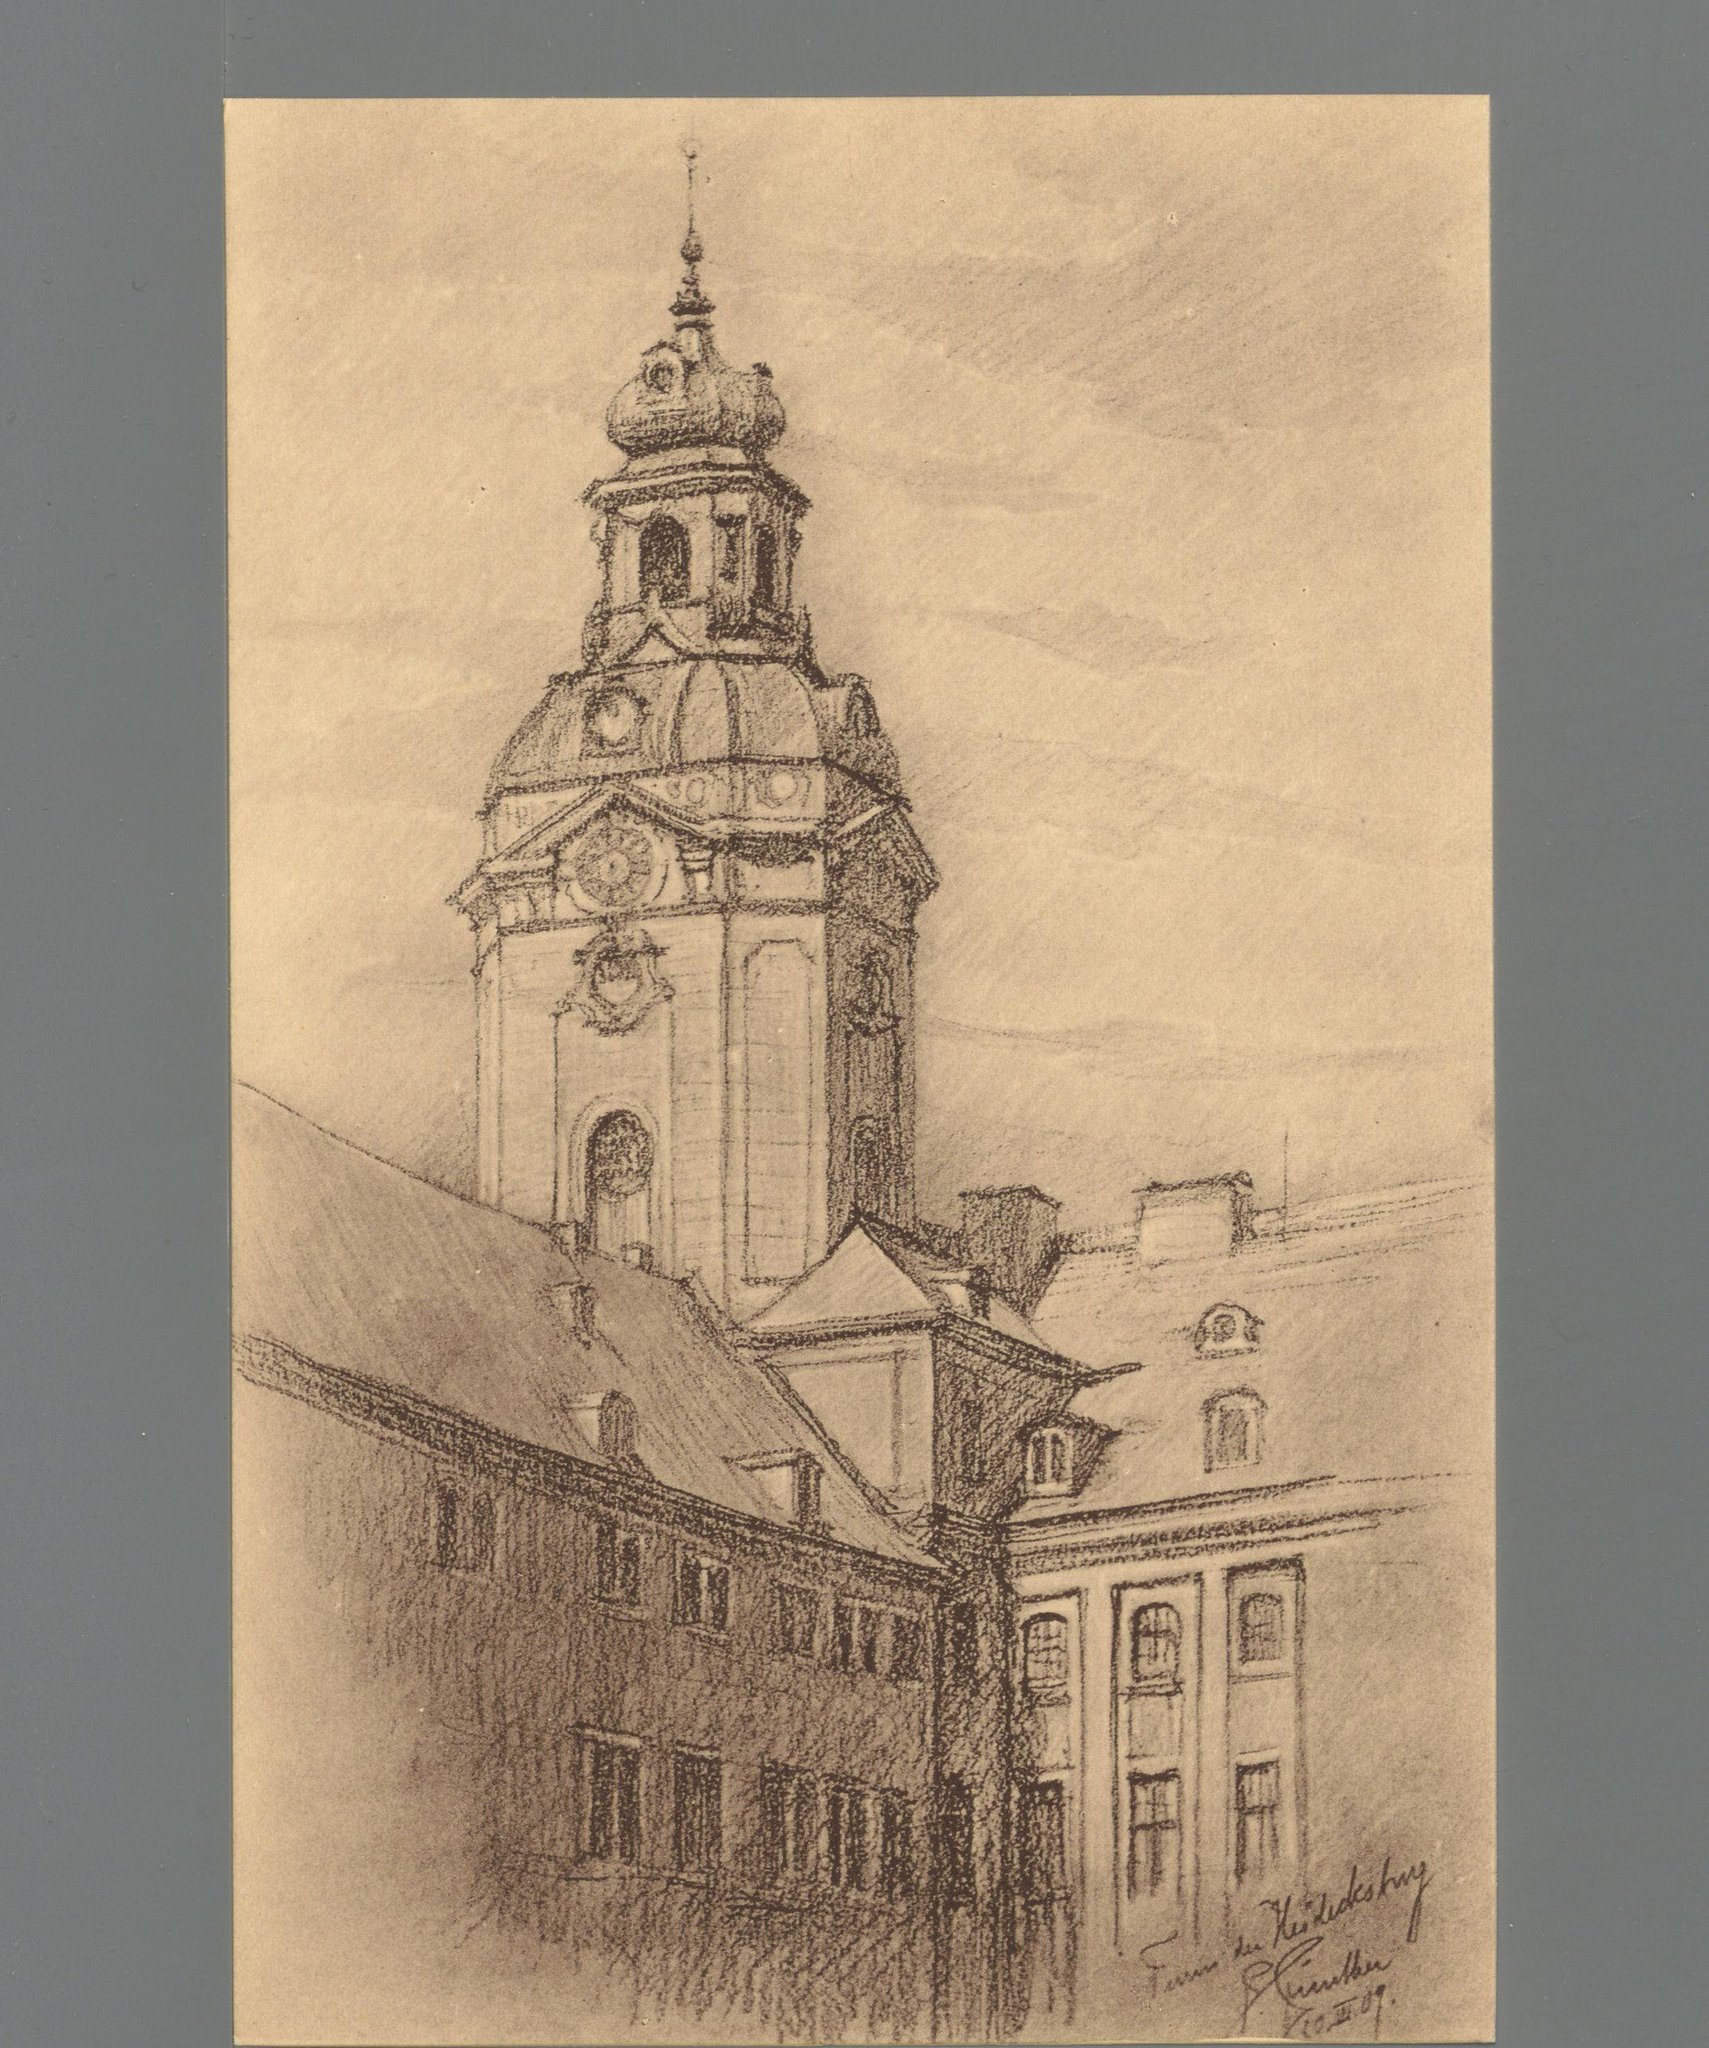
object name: reproduction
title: Rudolstadt. Turm der Heidecksburg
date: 1915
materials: cardboard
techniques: photograph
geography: rudolstadt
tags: castle